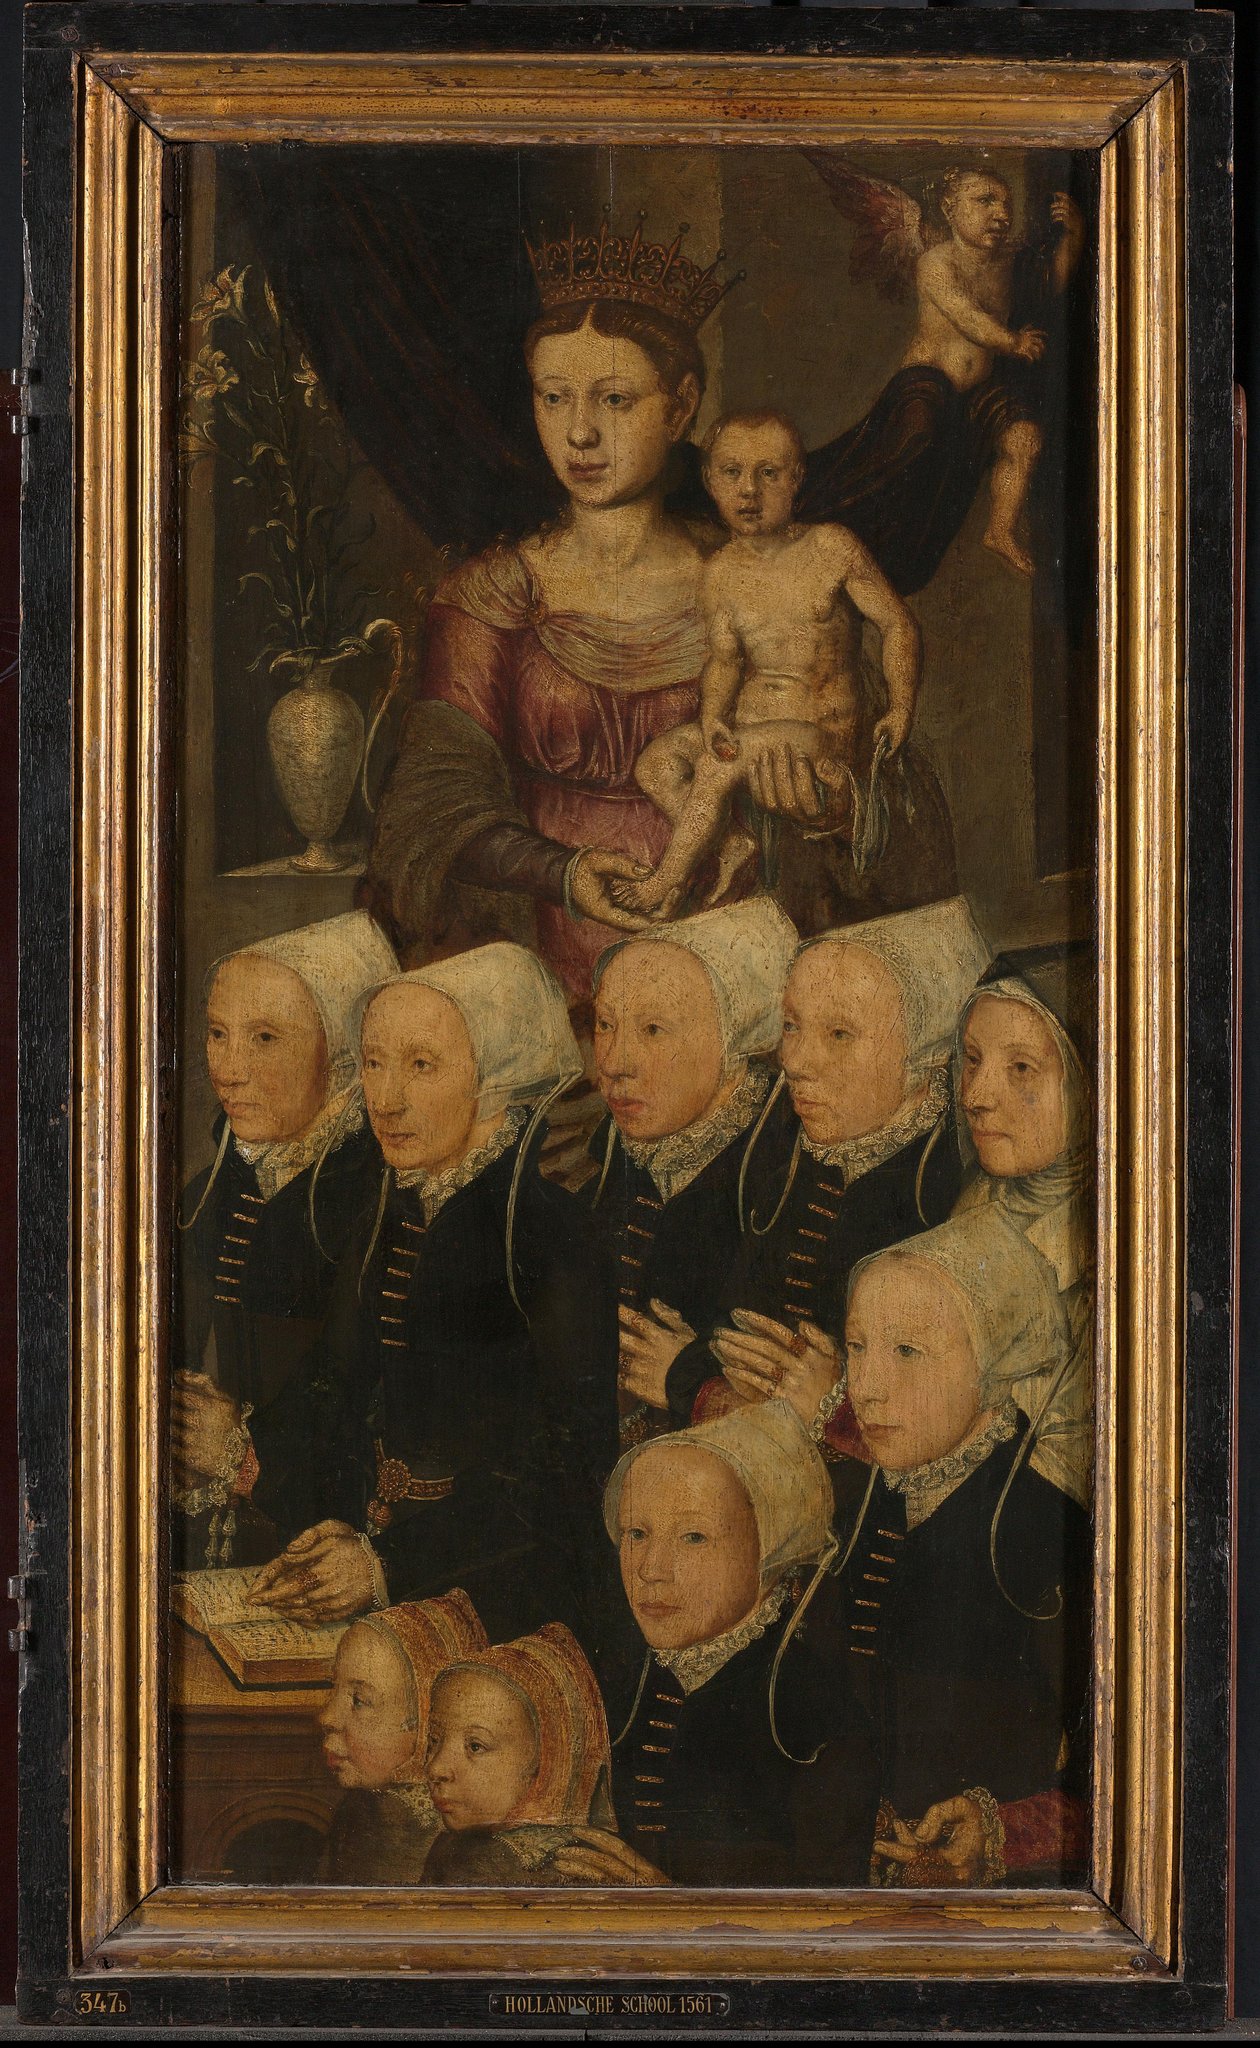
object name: painting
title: Right wing of a Memorial Triptych, formerly called the Gertz Memorial Triptych, with nine female Donor Portraits with the Virgin and Child (inner), and Saint Mary Magdalene (outer)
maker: Anonymous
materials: oil, panel, wood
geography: low countries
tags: madonna: i.e. mary with the christ-child (+ donor(s), supplicant(s), whether or not with patron saint(s))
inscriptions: inscription: ‘61’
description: Rechtervleugel van de Gertz memorietafel. Op de binnenzijde van het rechter zijpaneel de echtgenote van de stichter, Styntgen Dirck Claesgens met haar dochters en Maria met kind. Op de buitenkant van het paneel grisaille van Maria Magdalena. Met geïntegreerde originele lijst.